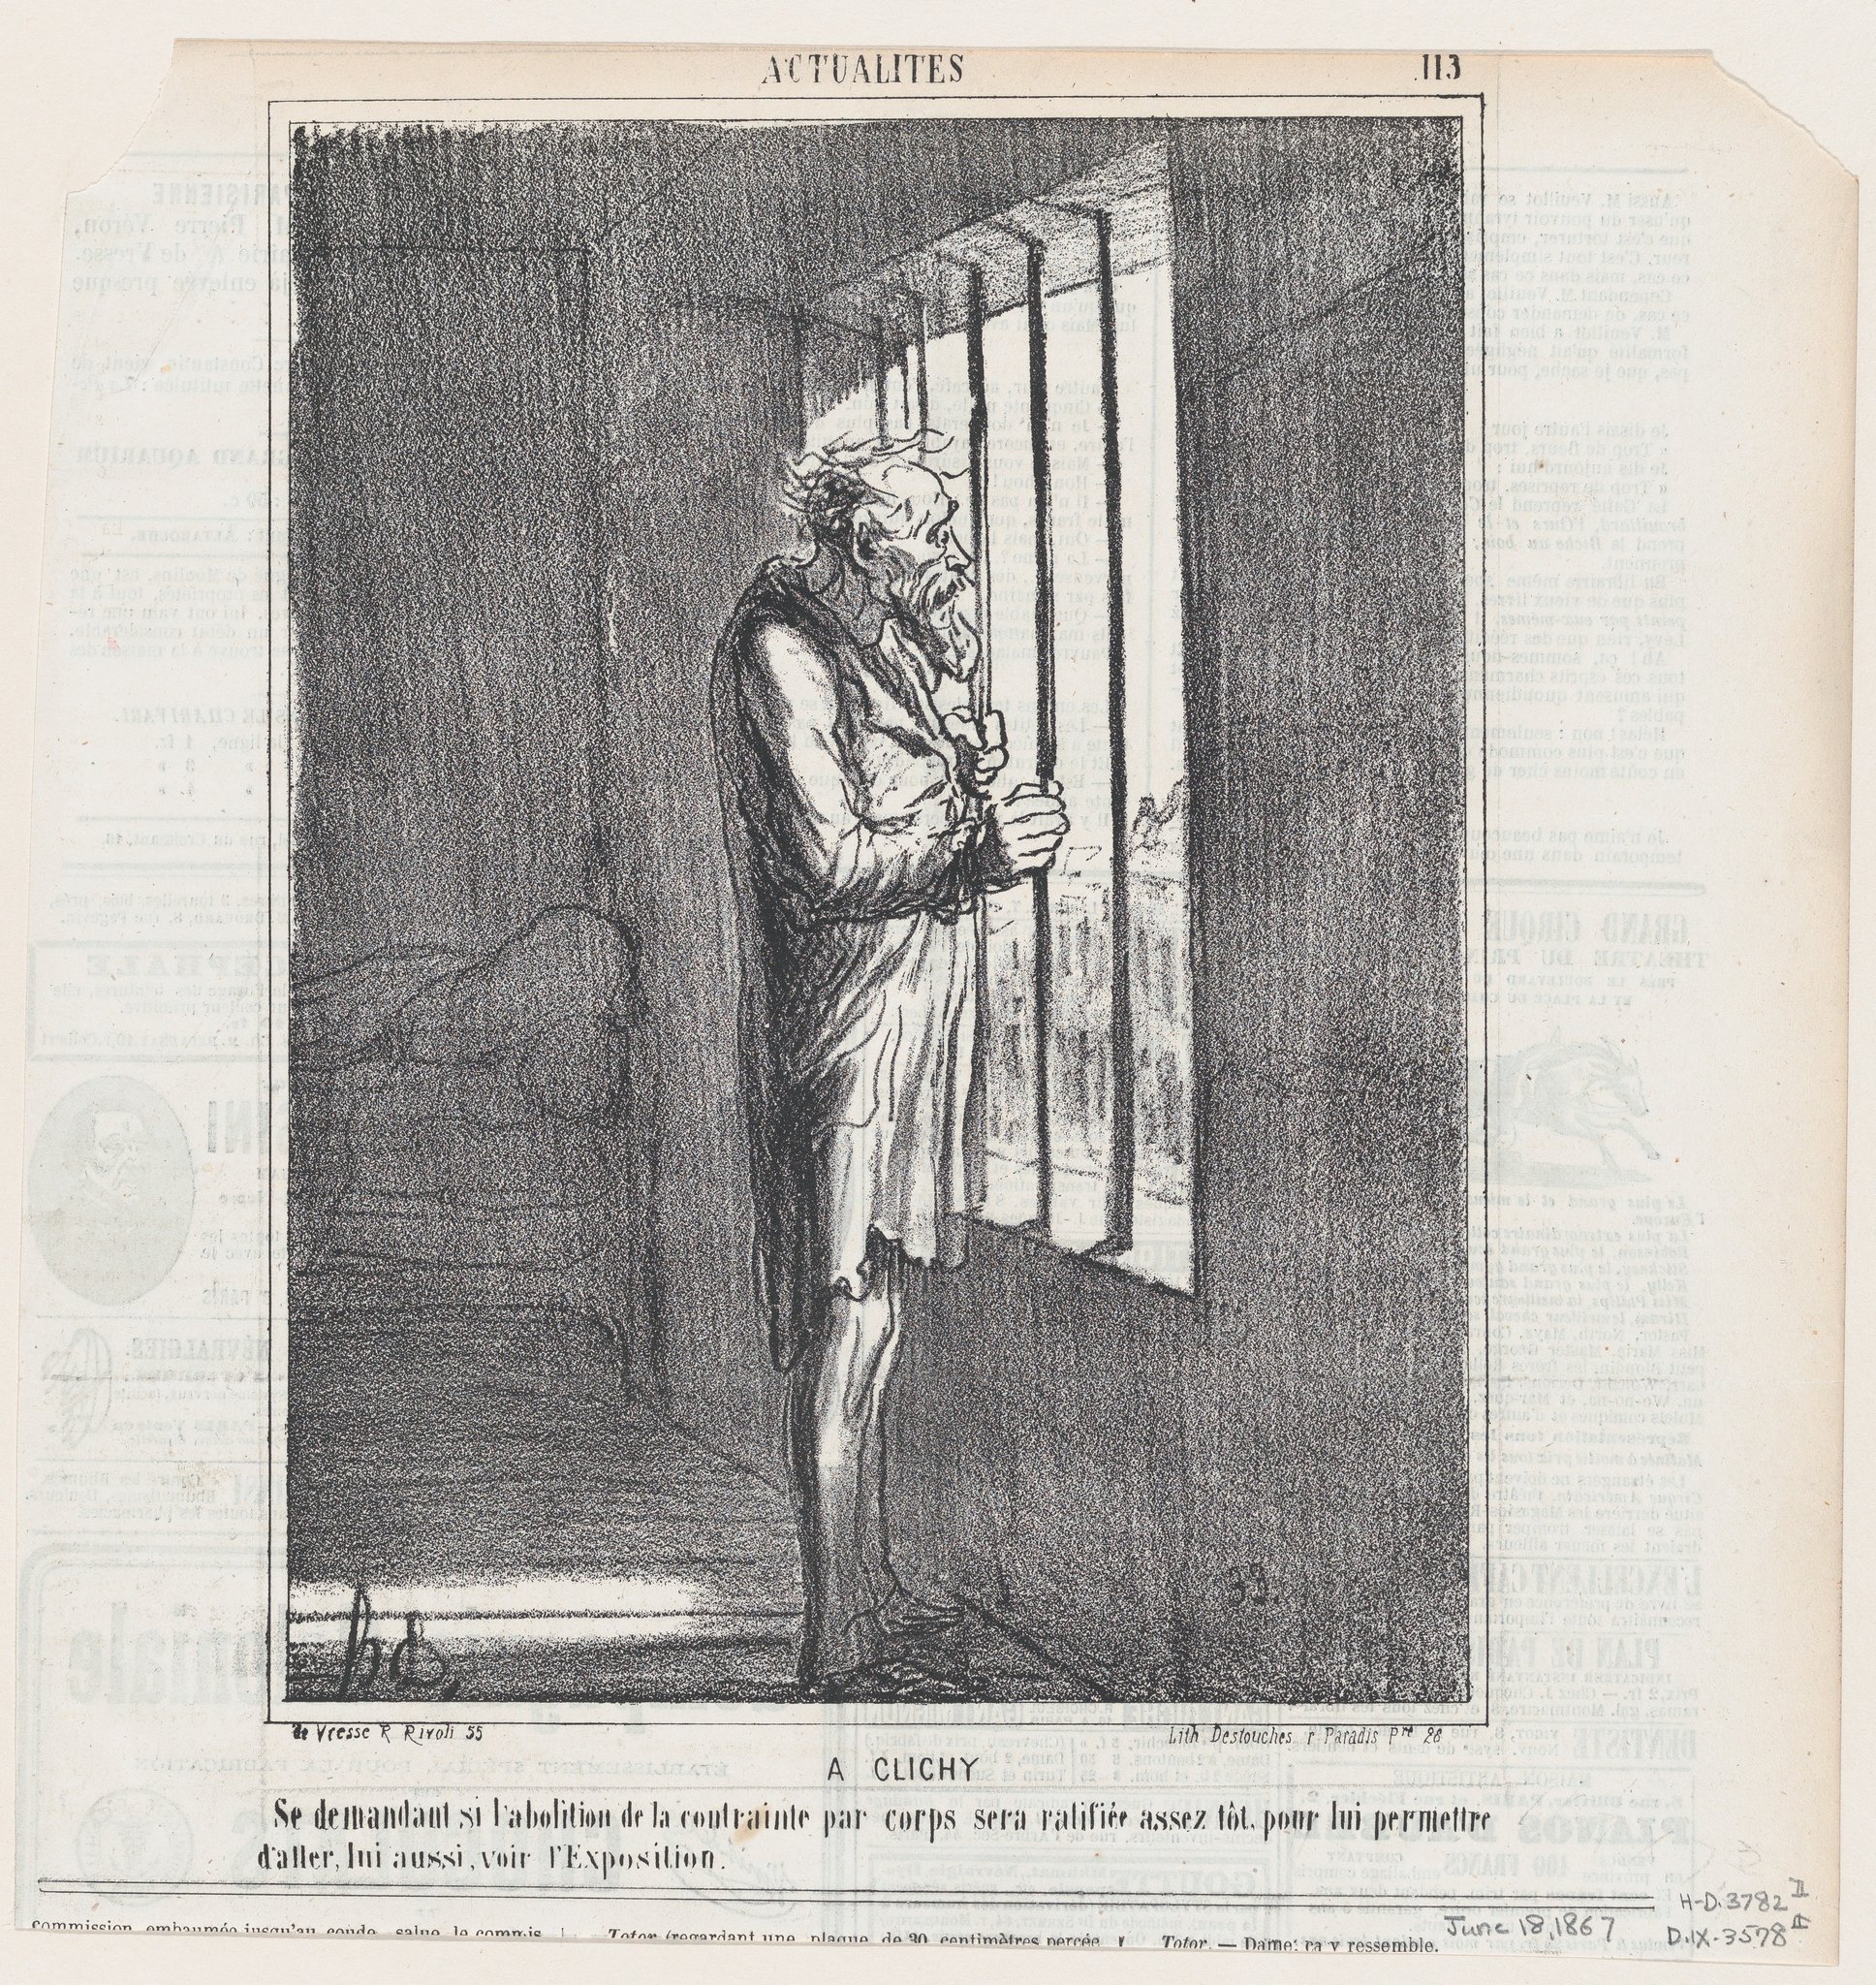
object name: print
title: In Clichy: wondering if the repeal of the sentence will be quickly ratified, to allow him to see the exhibition, from 'News of the day,' published in Le Charivari, June 18, 1867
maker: honoré daumier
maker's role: artist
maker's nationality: french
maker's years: 1808-1879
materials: paper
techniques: lithograph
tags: prisons,prisoners,men